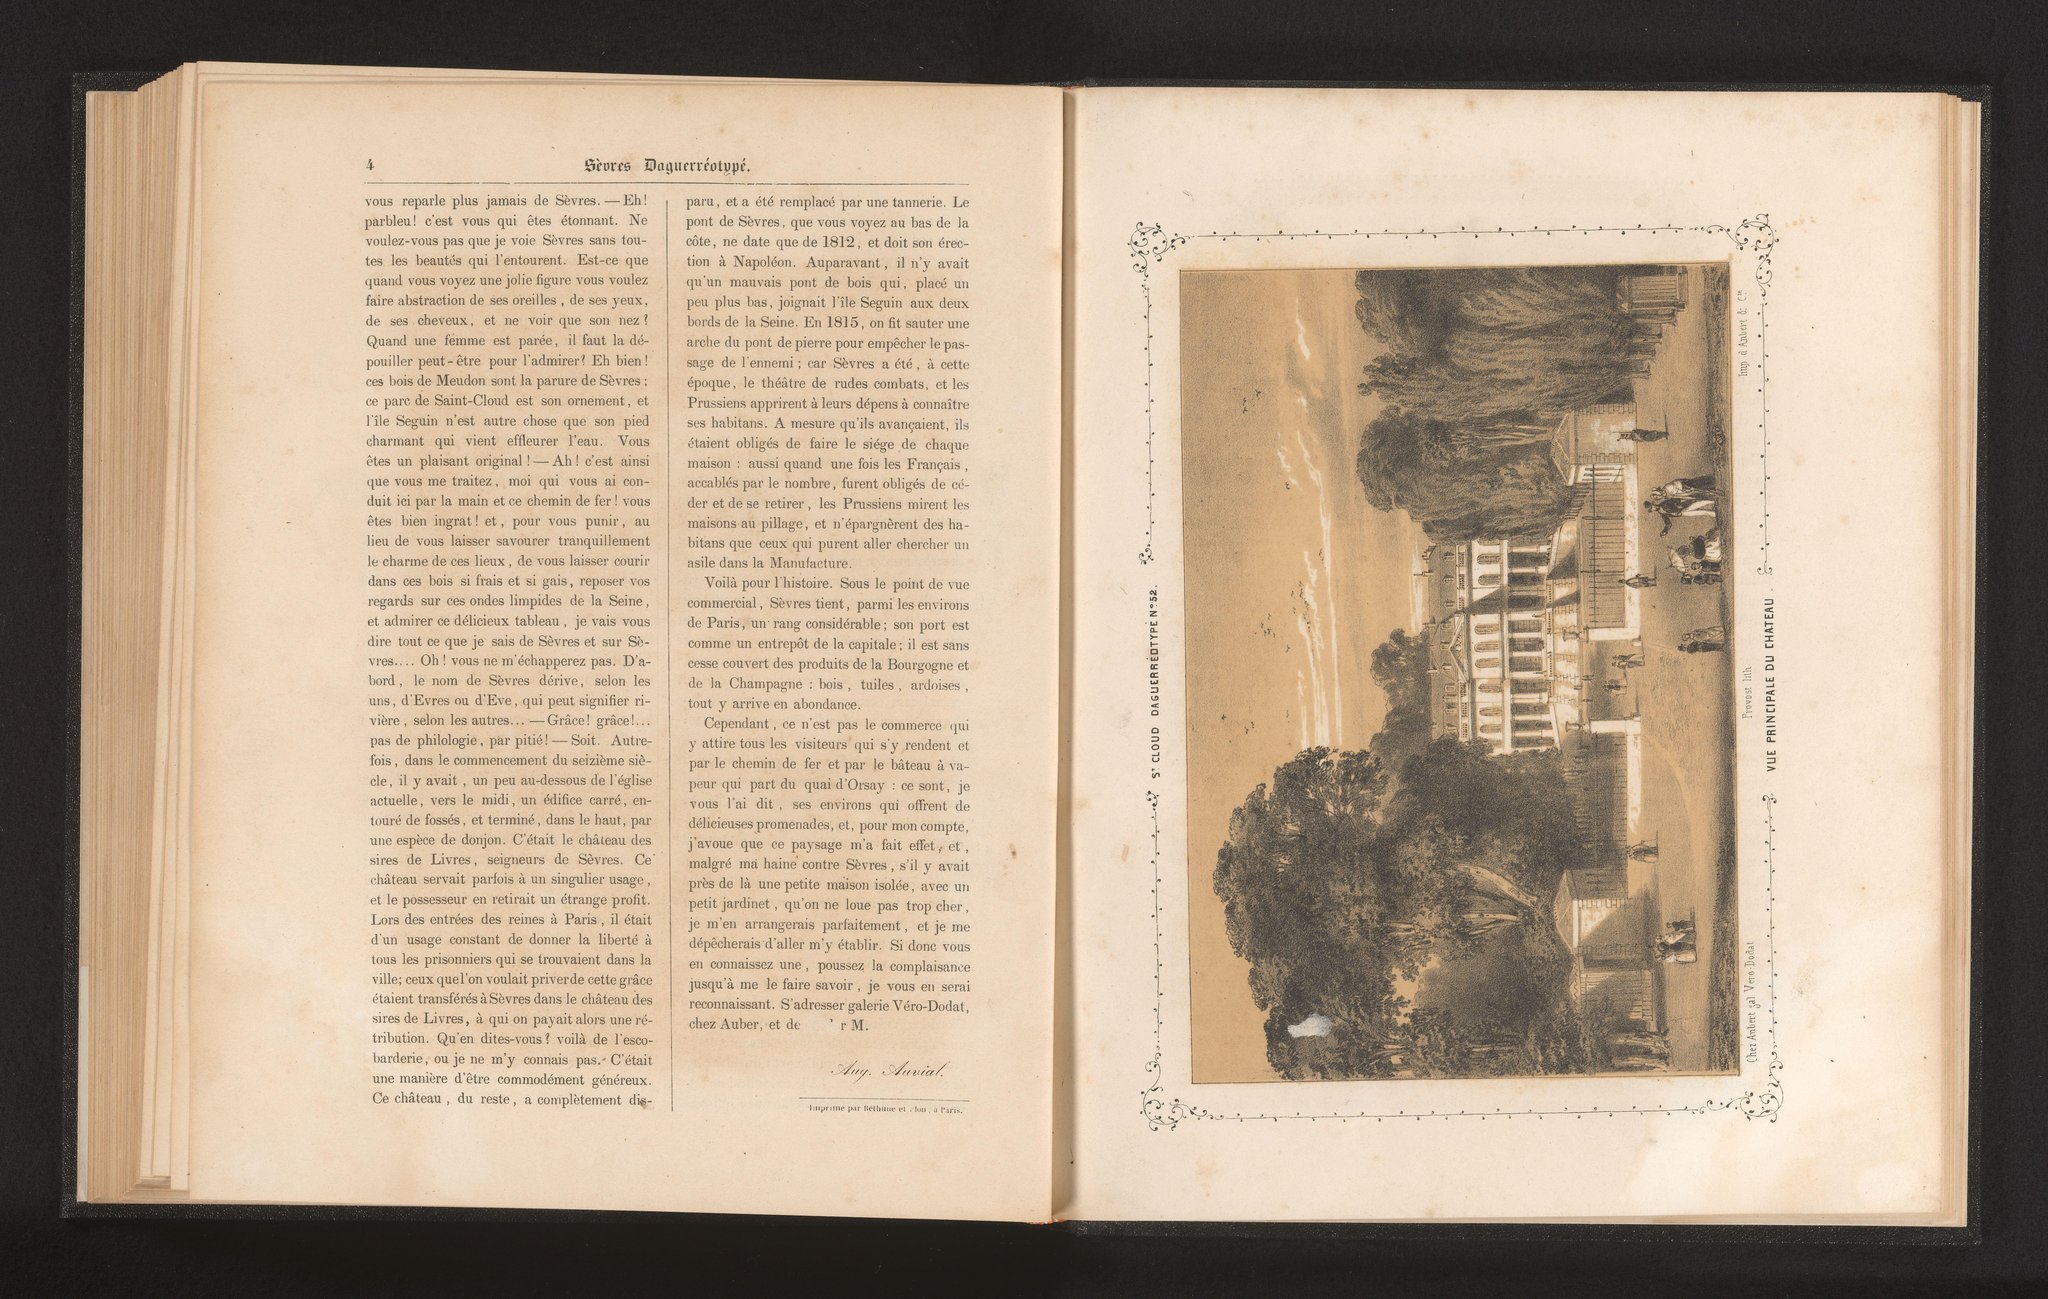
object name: page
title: Vue principale du chateau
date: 1839-1840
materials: paper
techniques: tone lithography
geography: paris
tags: palace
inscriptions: inscription: ‘St. CLOUD DAGUERRÉOTYPÉ No. 52.’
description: Prent op tweehonderdenzevende ongenummerde pagina.